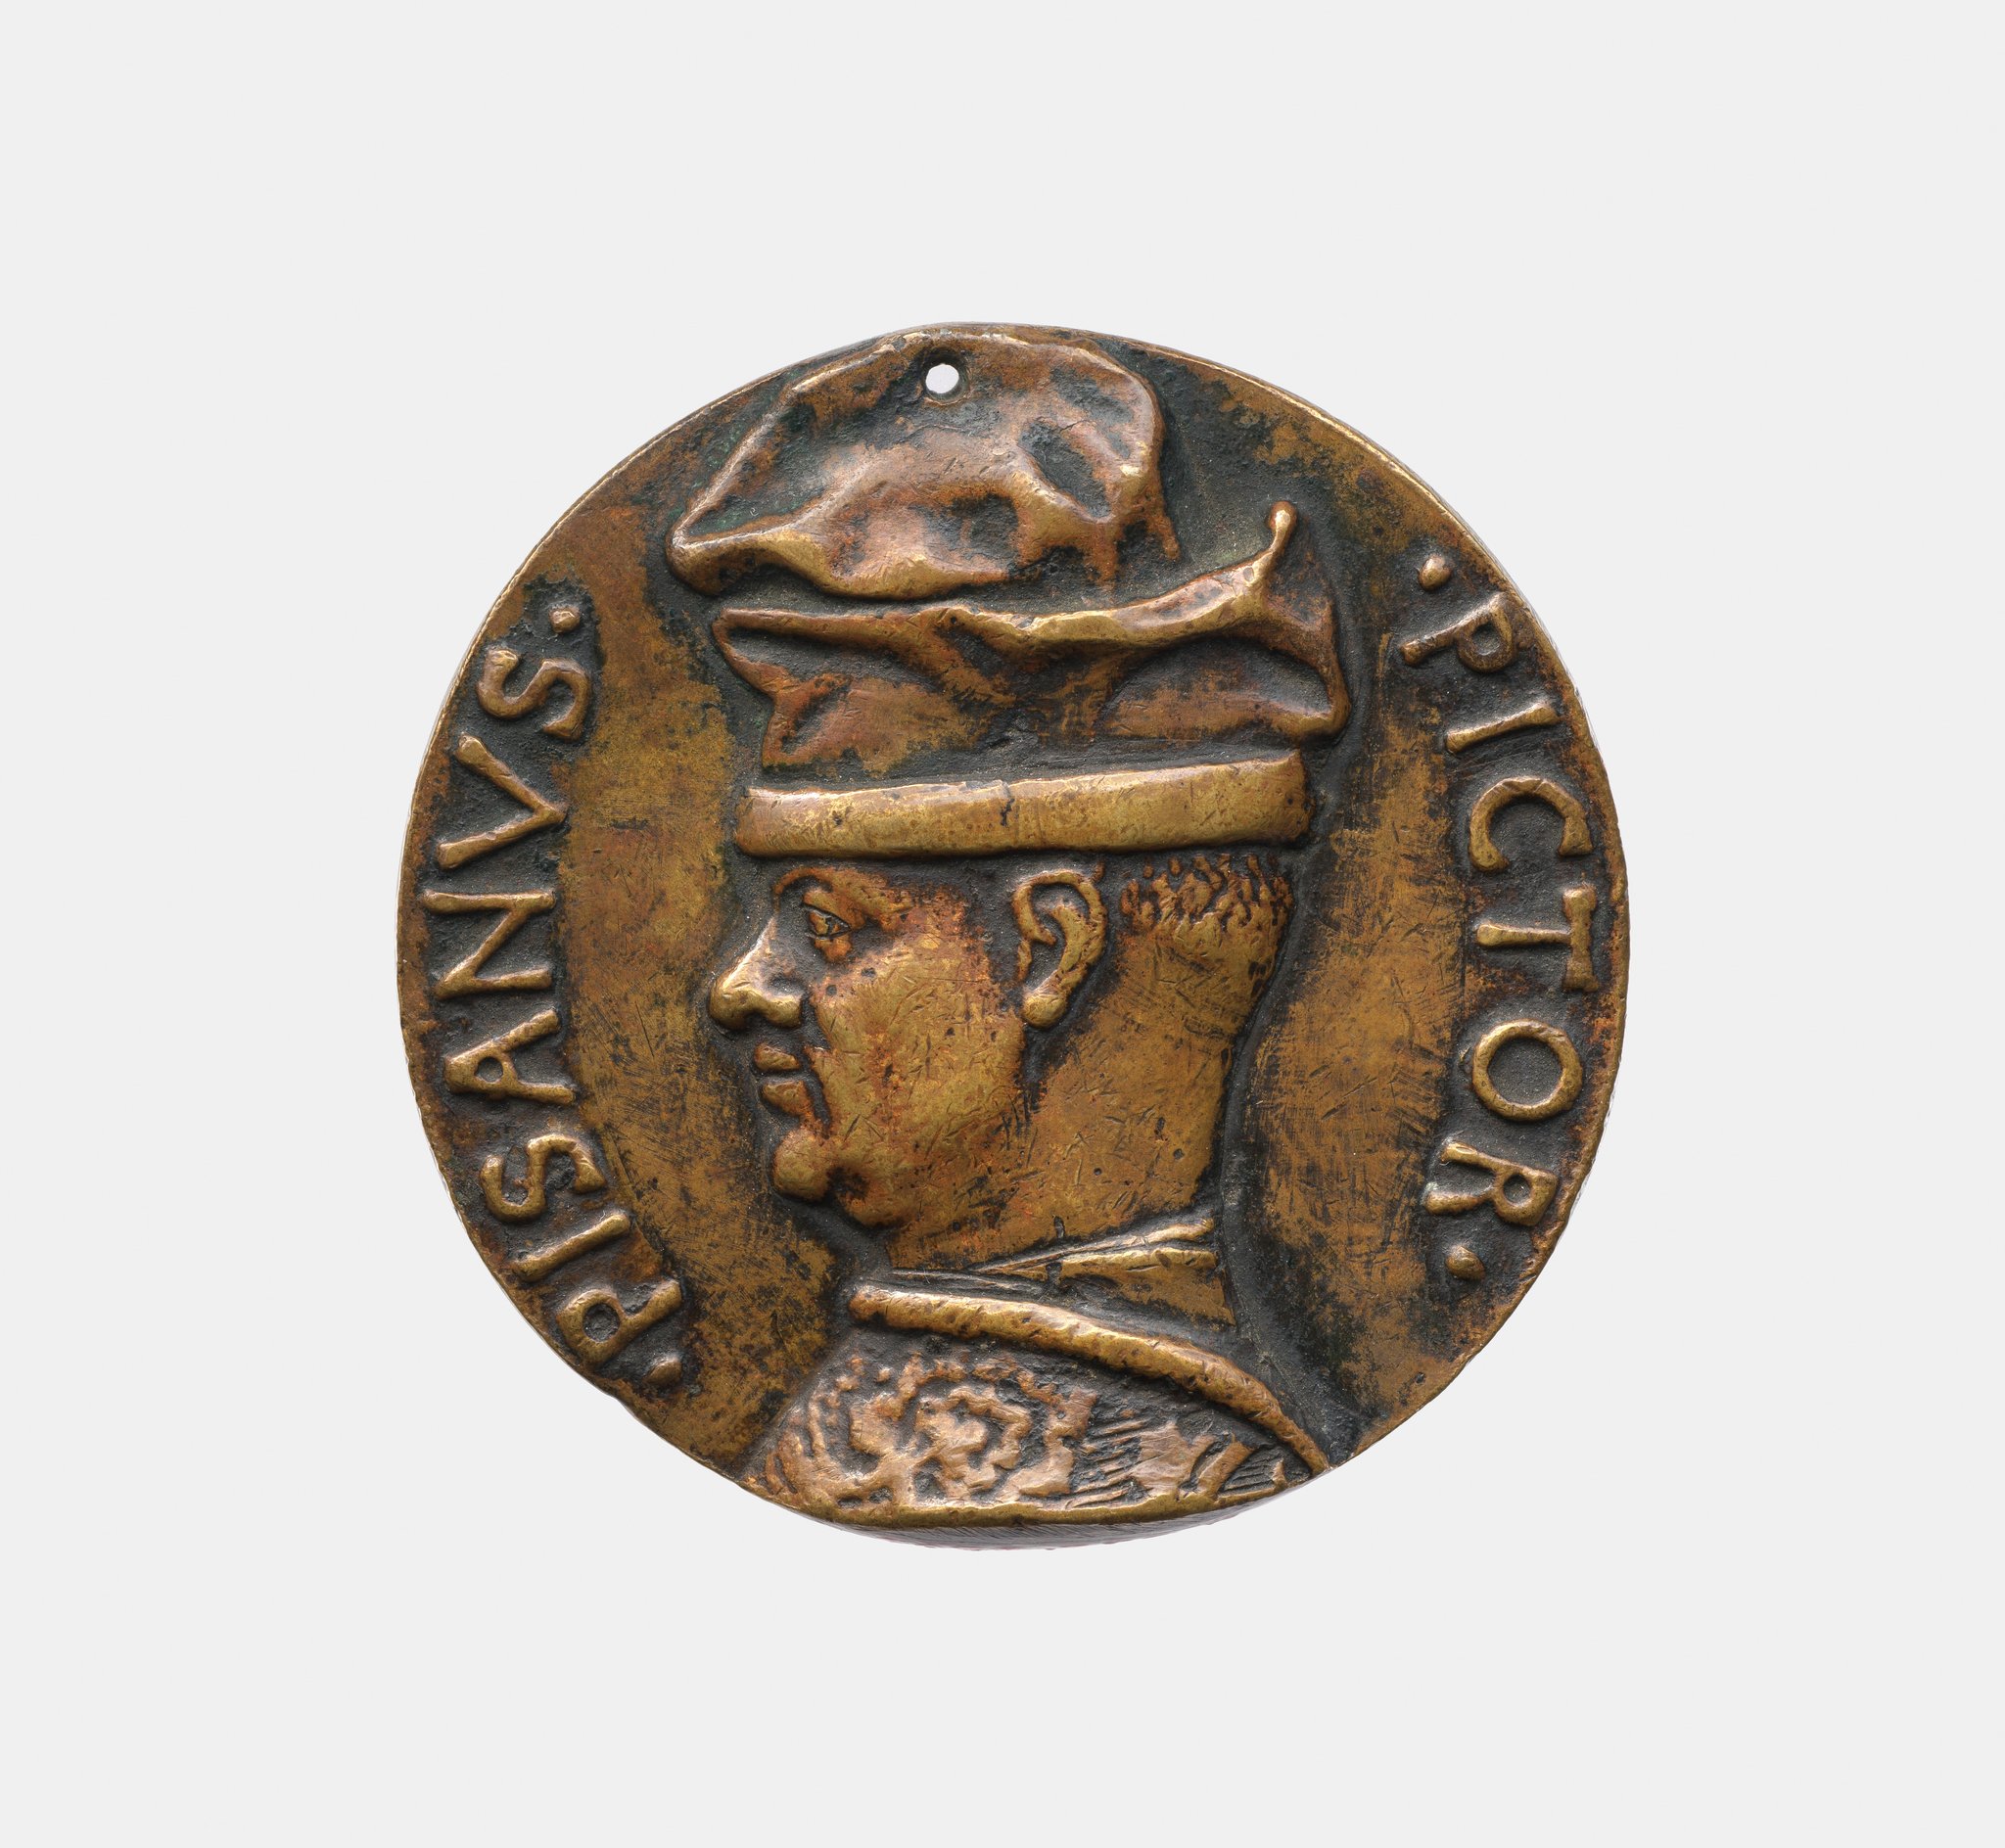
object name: medal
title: Antonio Pisano called Pisanello (ca. 1395–1455)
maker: Anonymous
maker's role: artist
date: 1450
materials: bronze